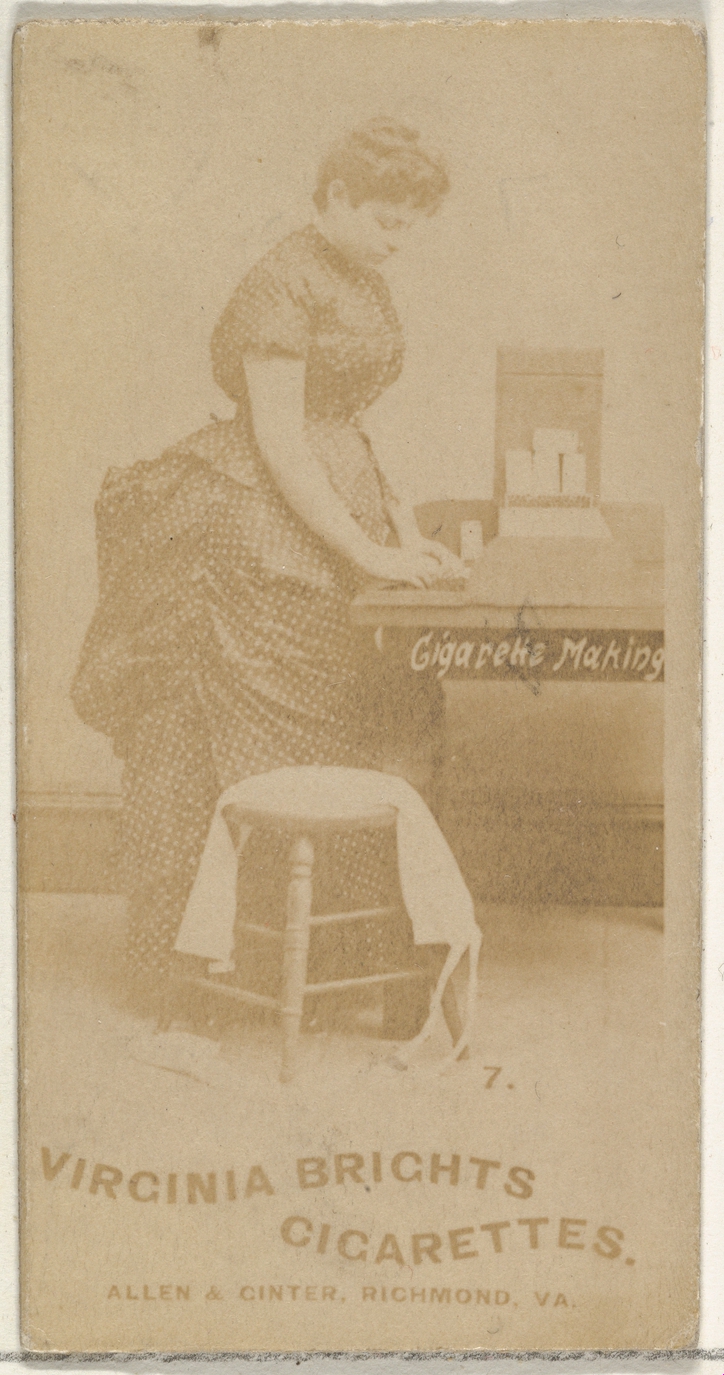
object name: photograph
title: Card 7, from the series, Cigarette Making Girls (N46) for Virginia Brights Cigarettes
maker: allen & ginter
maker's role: publisher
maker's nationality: american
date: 1888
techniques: albumen silver print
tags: women